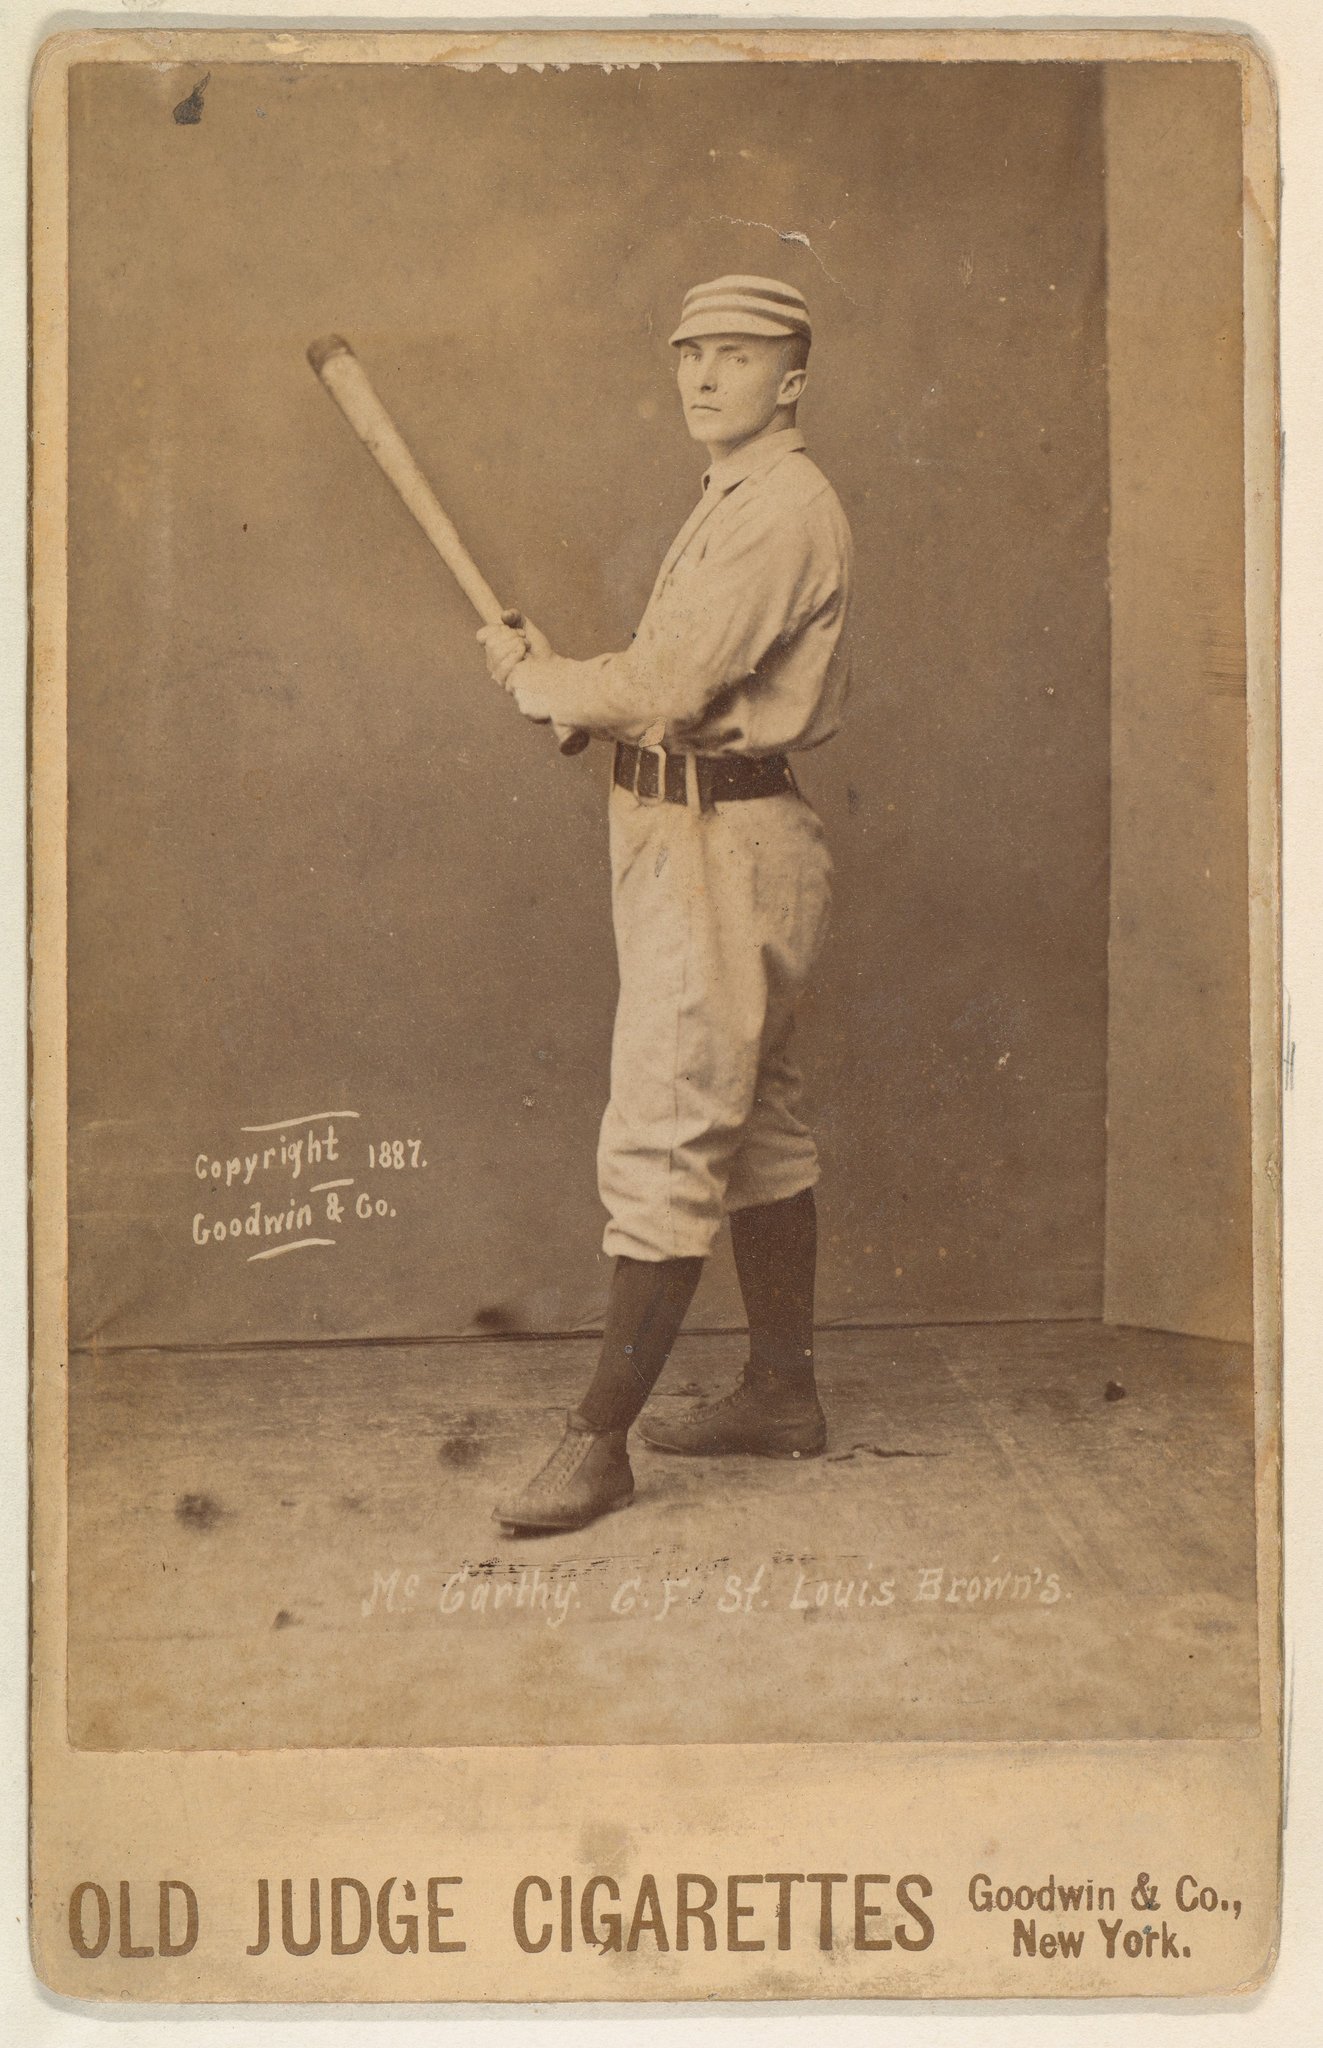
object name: baseball card, photograph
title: McCarthy, Center Field, St. Louis Browns, from the series Old Judge Cigarettes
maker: goodwin & company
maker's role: publisher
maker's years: 1850-1950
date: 1887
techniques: albumen print, photography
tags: men,portraits,baseball,athletes